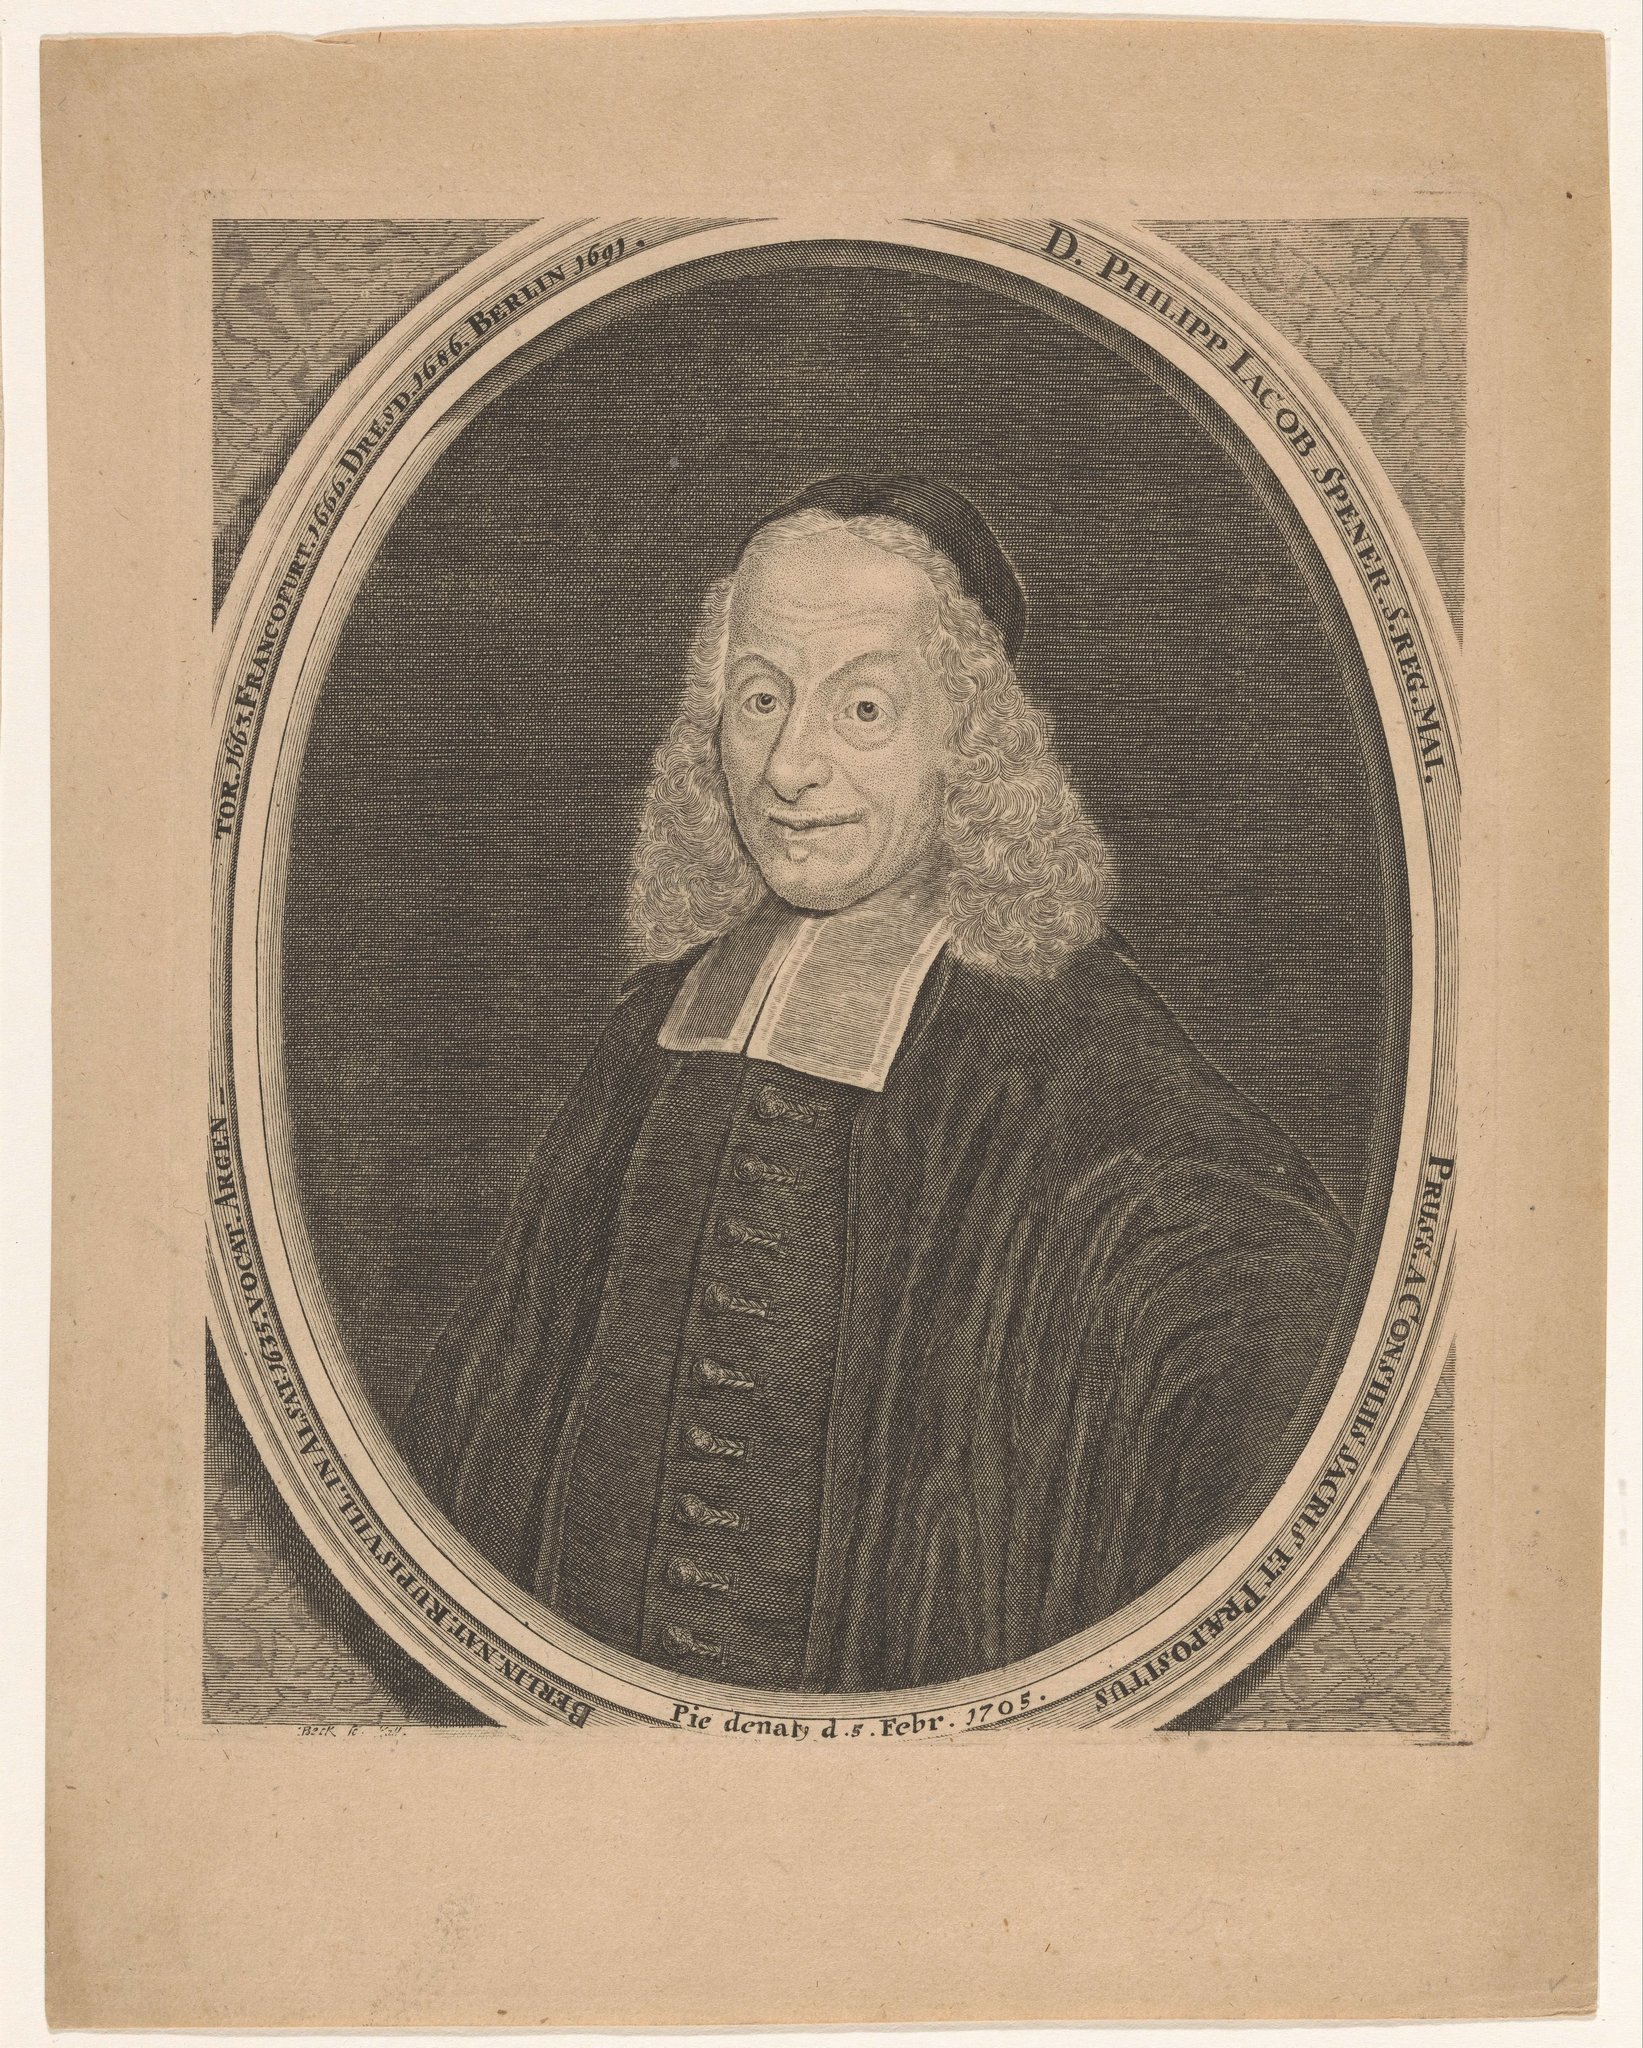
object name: print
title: Portret van Philipp Jacob Spener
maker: johann georg beck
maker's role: print maker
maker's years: 1676-1722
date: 1706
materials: paper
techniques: engraving, etching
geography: halle an der saale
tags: berlin, philipp jacob spener, historical persons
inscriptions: collector's mark: Lugt 2228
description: Prent ook gebruikt in: Spener, Philipp Jacob. Lauterkeit Des Evangelischen Christenthums In auserlesenen Predigen verfasset. Halle an der Saale: Waisenhausdruckerei, 1706.